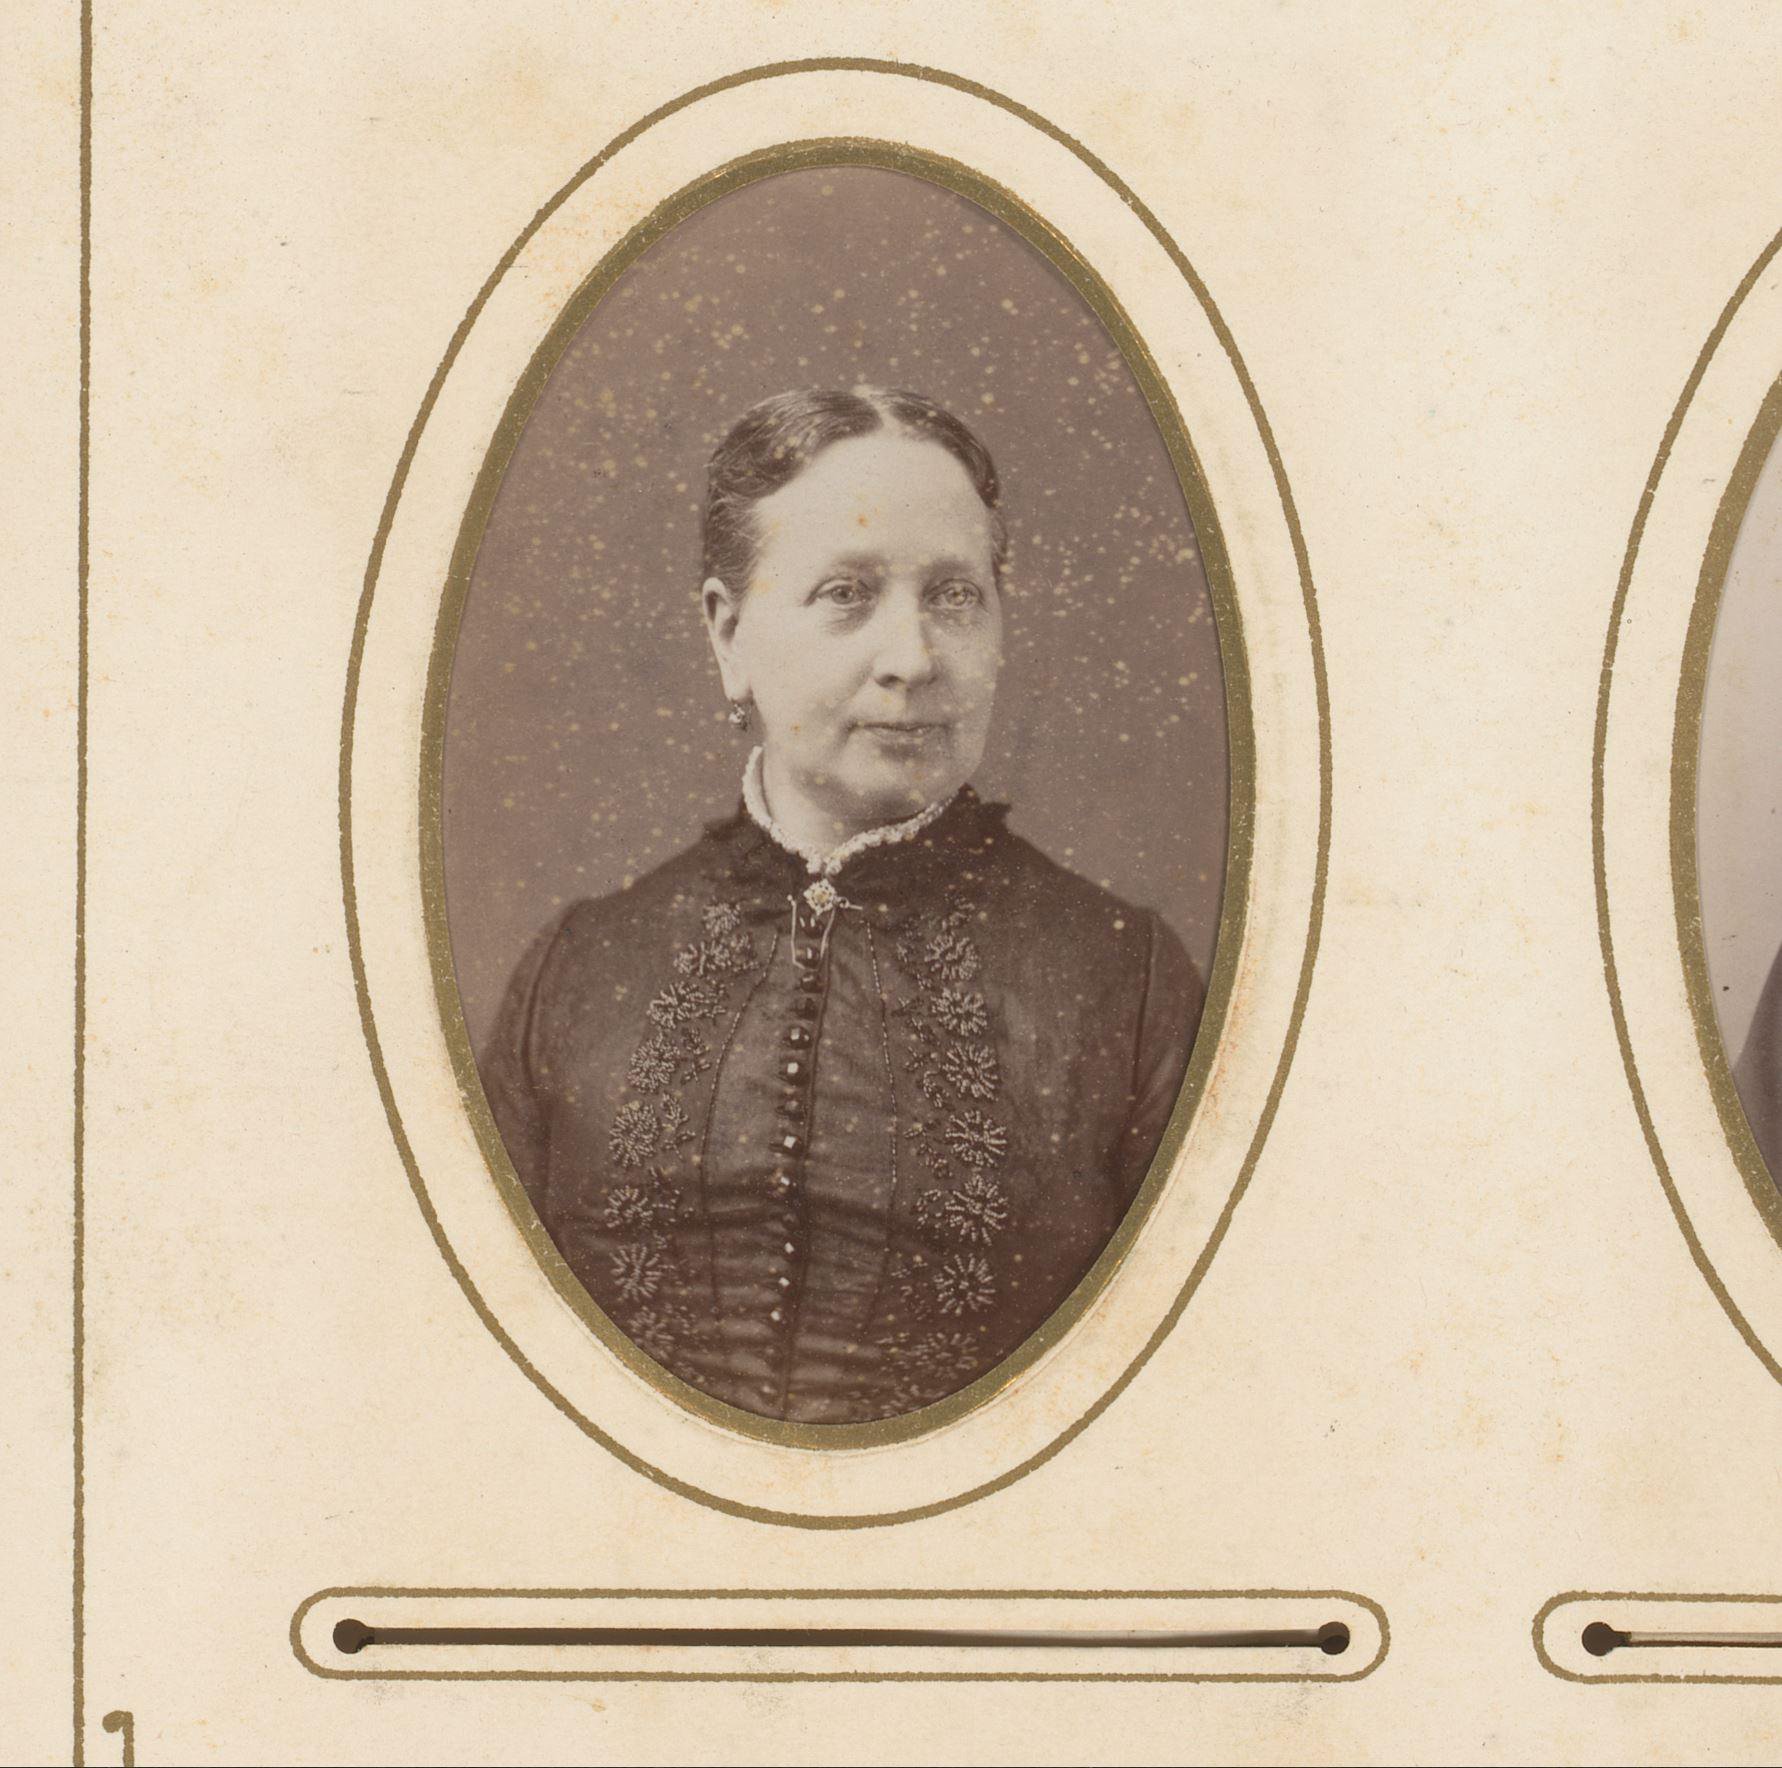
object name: photograph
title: Portret van een vrouw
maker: idanus hendrikus slaterus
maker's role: fotograaf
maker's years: 1846-1921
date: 1868-1909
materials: cardboard, photographic support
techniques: albumen print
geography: leeuwarden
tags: historical persons - bb - woman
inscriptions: inscription: ‘Photographie/ I. H. Slaterus/ Leeuwarden/ Weerd K. 13,/ hoek Bagÿnestraat.’